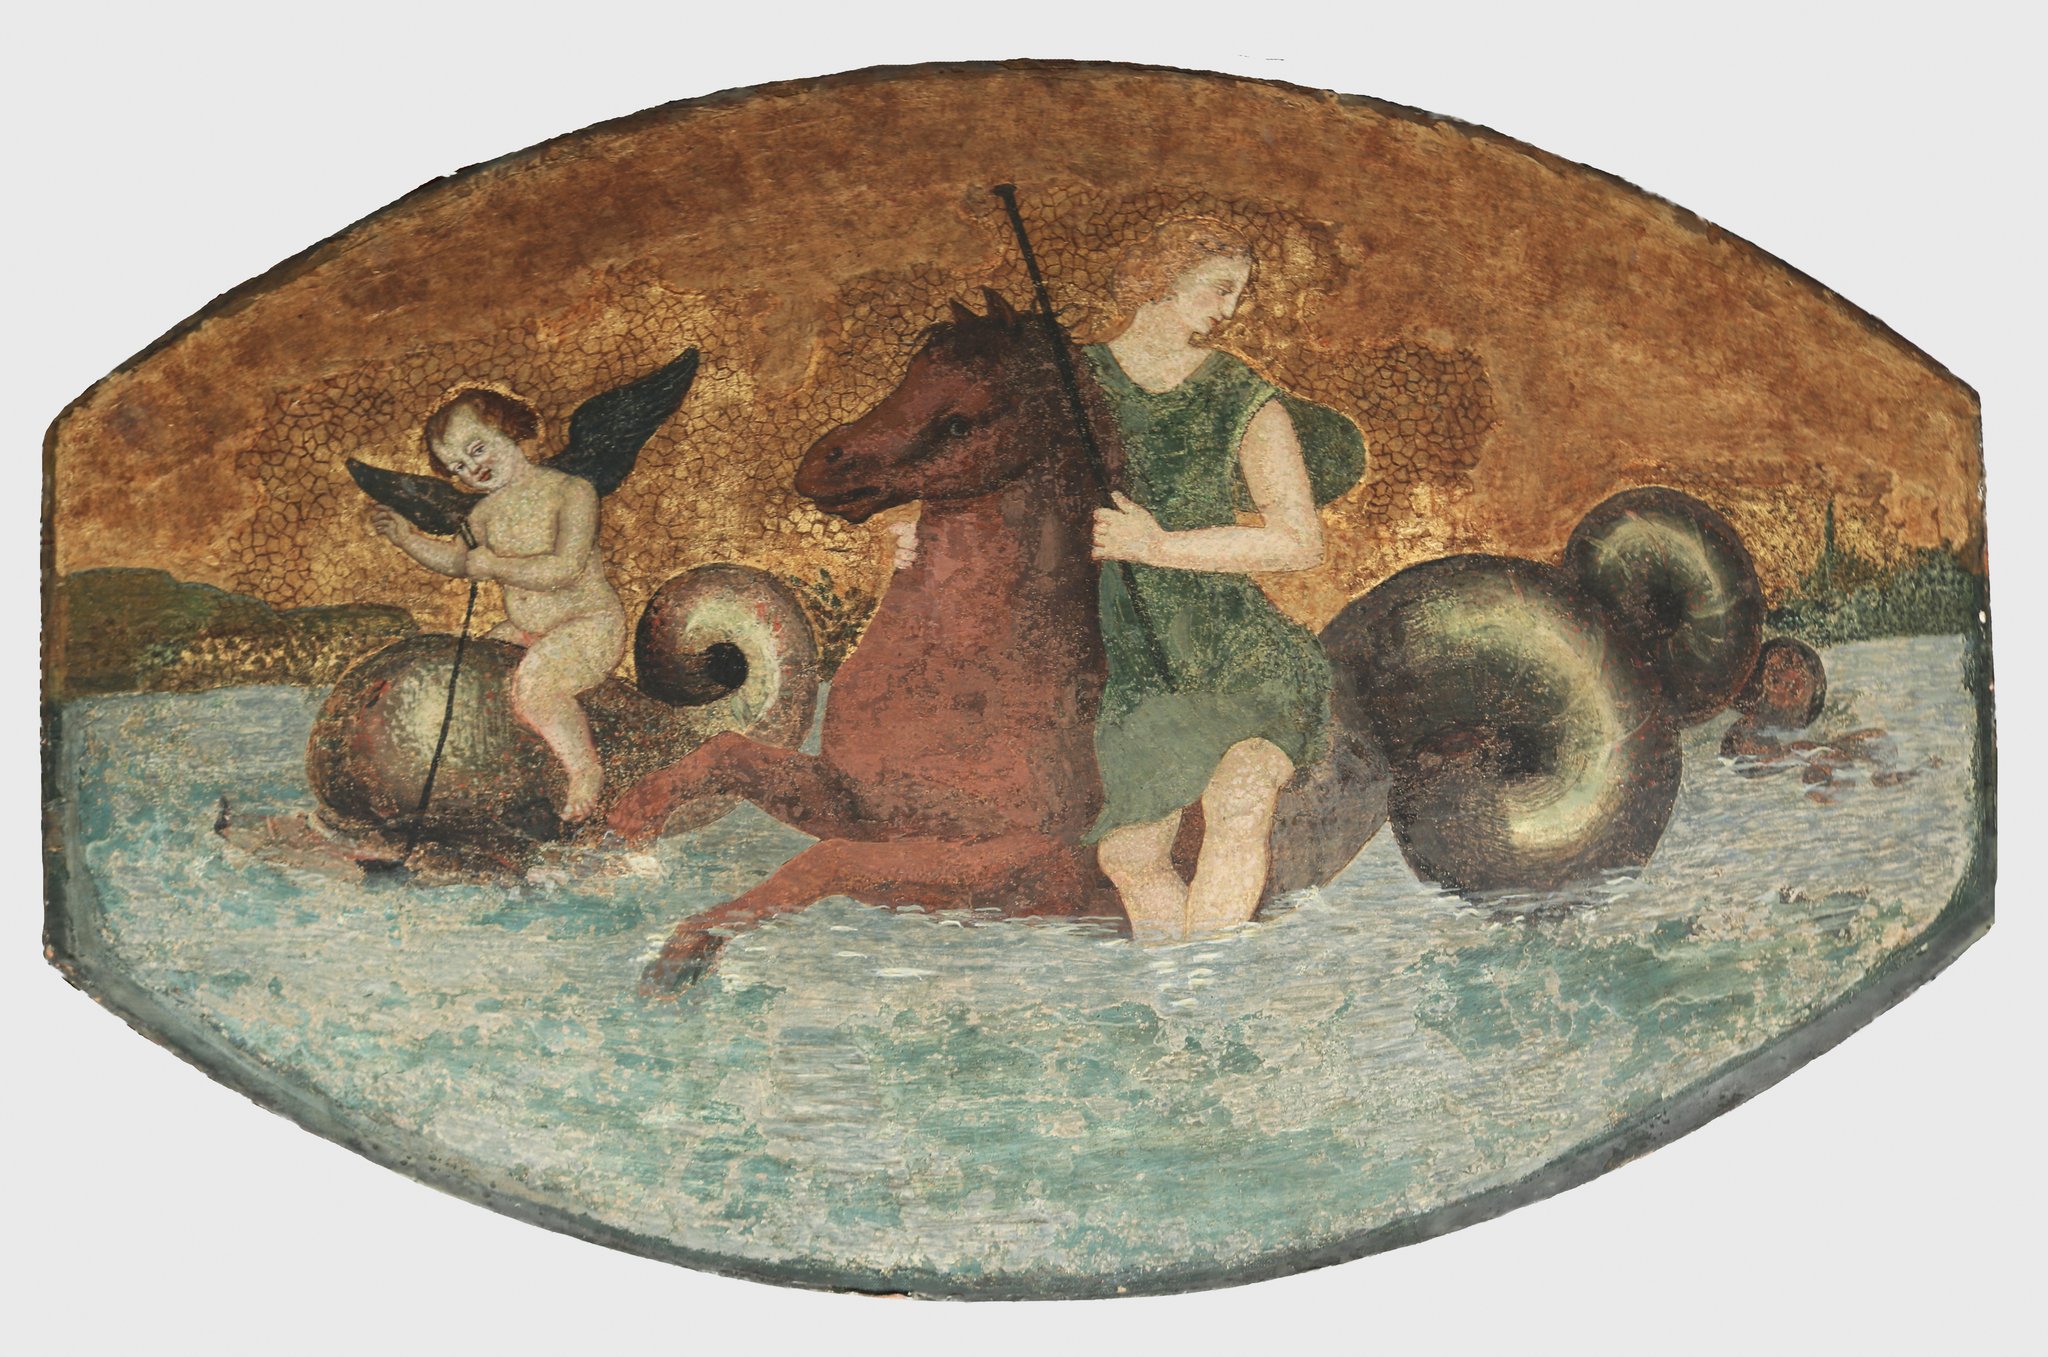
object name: ceiling panel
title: Galatea (?)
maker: pinturicchio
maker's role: artist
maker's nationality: italian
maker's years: 1454-1513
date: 1509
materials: canvas, panel, wood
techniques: fresco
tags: women,cupid,horses